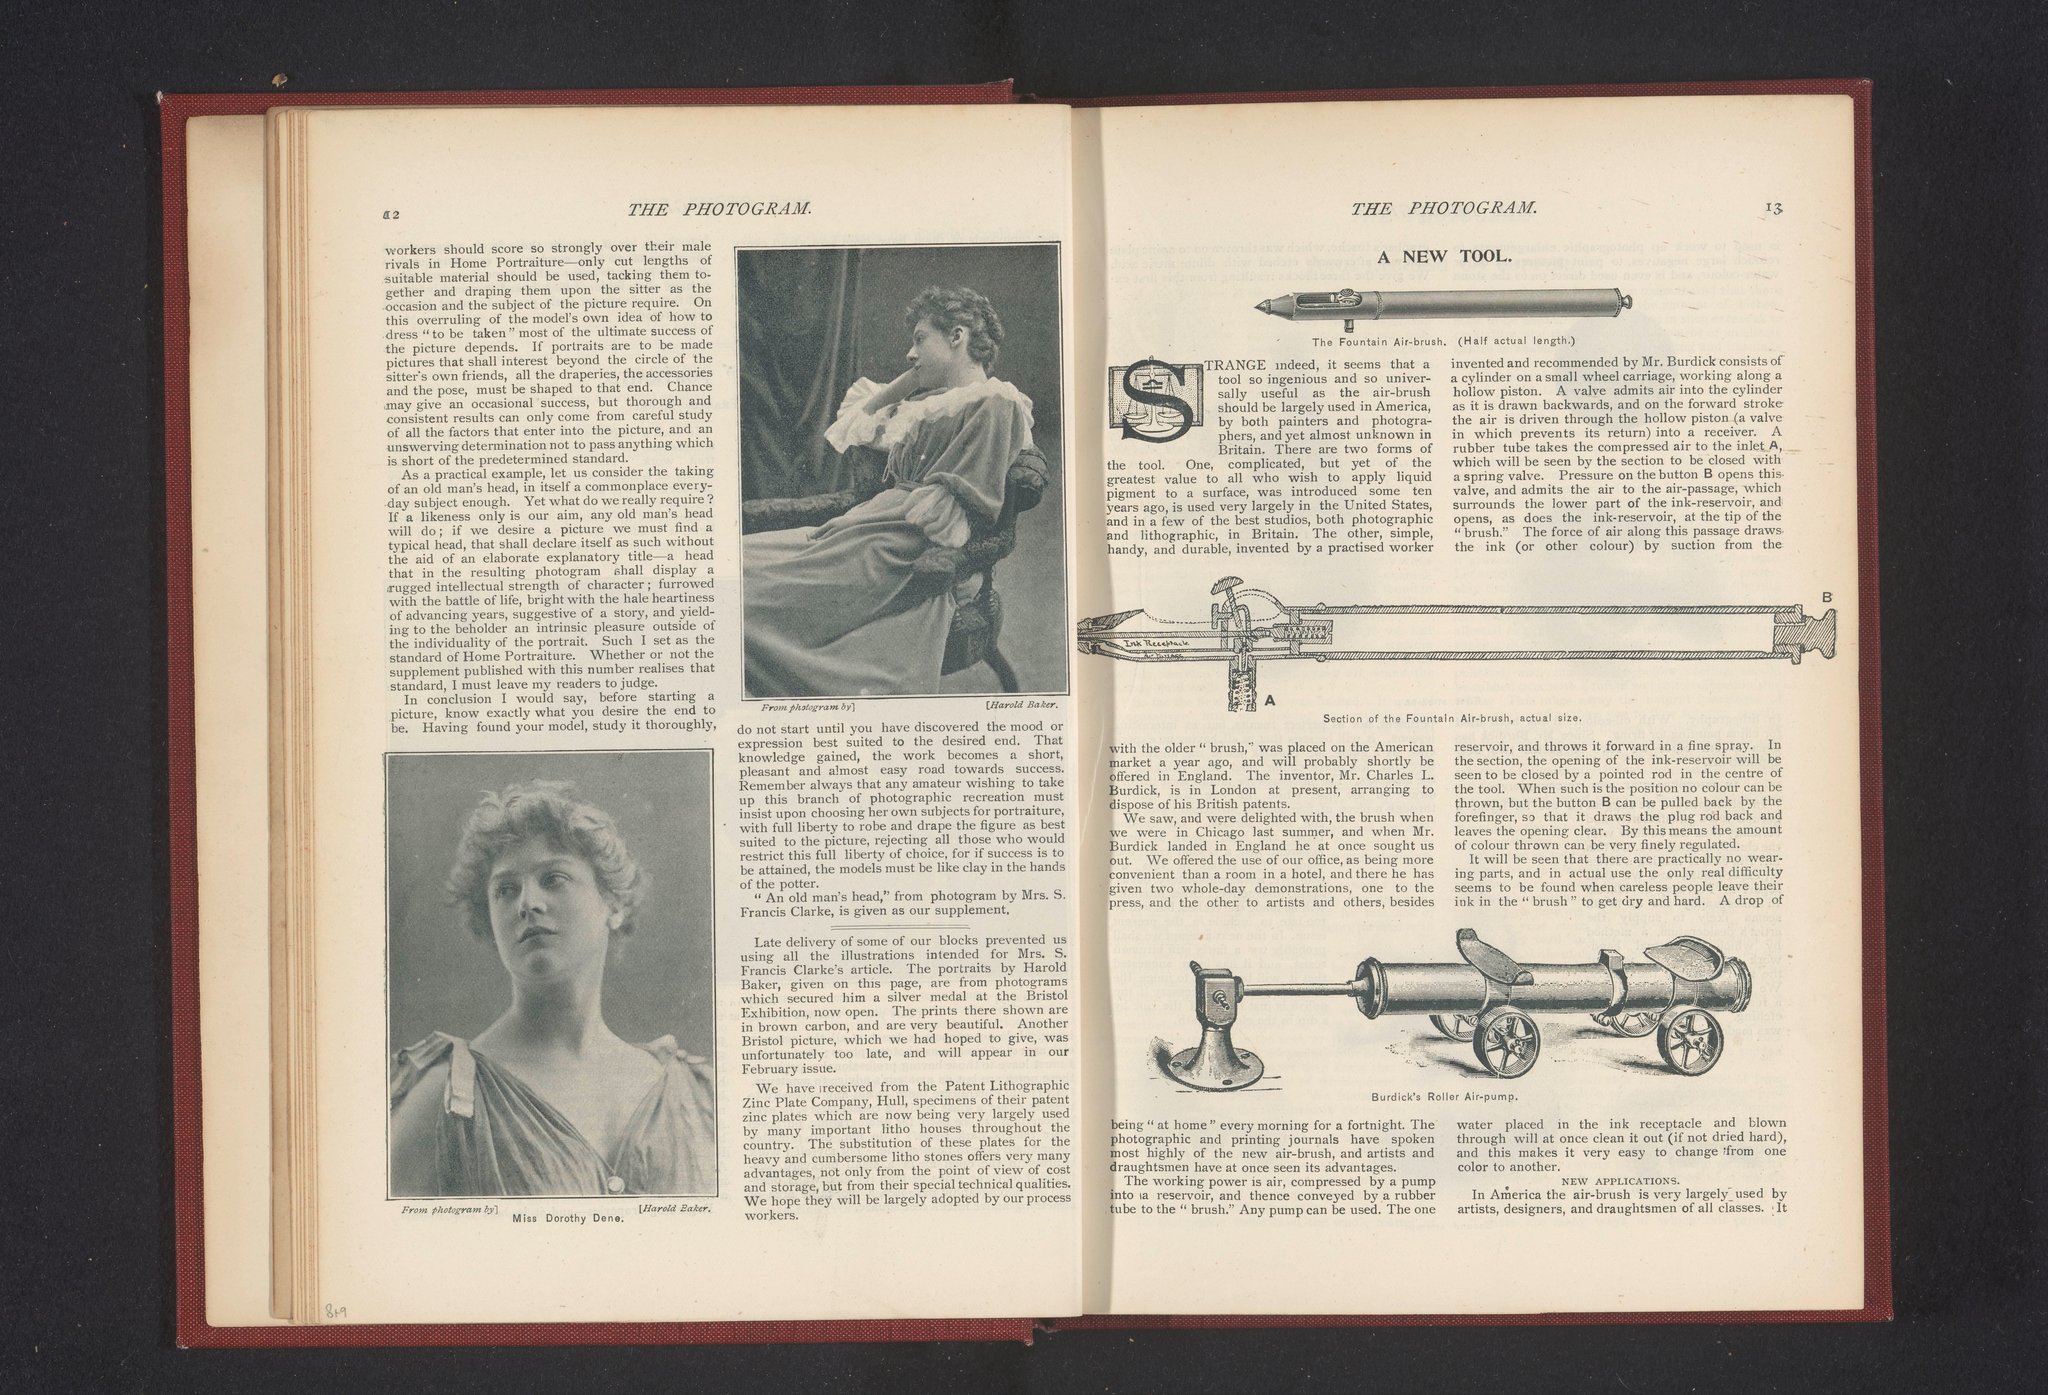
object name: page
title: Portret van Dorothy Dene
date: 1889-1894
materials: paper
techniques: autotype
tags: historical persons - bb - woman